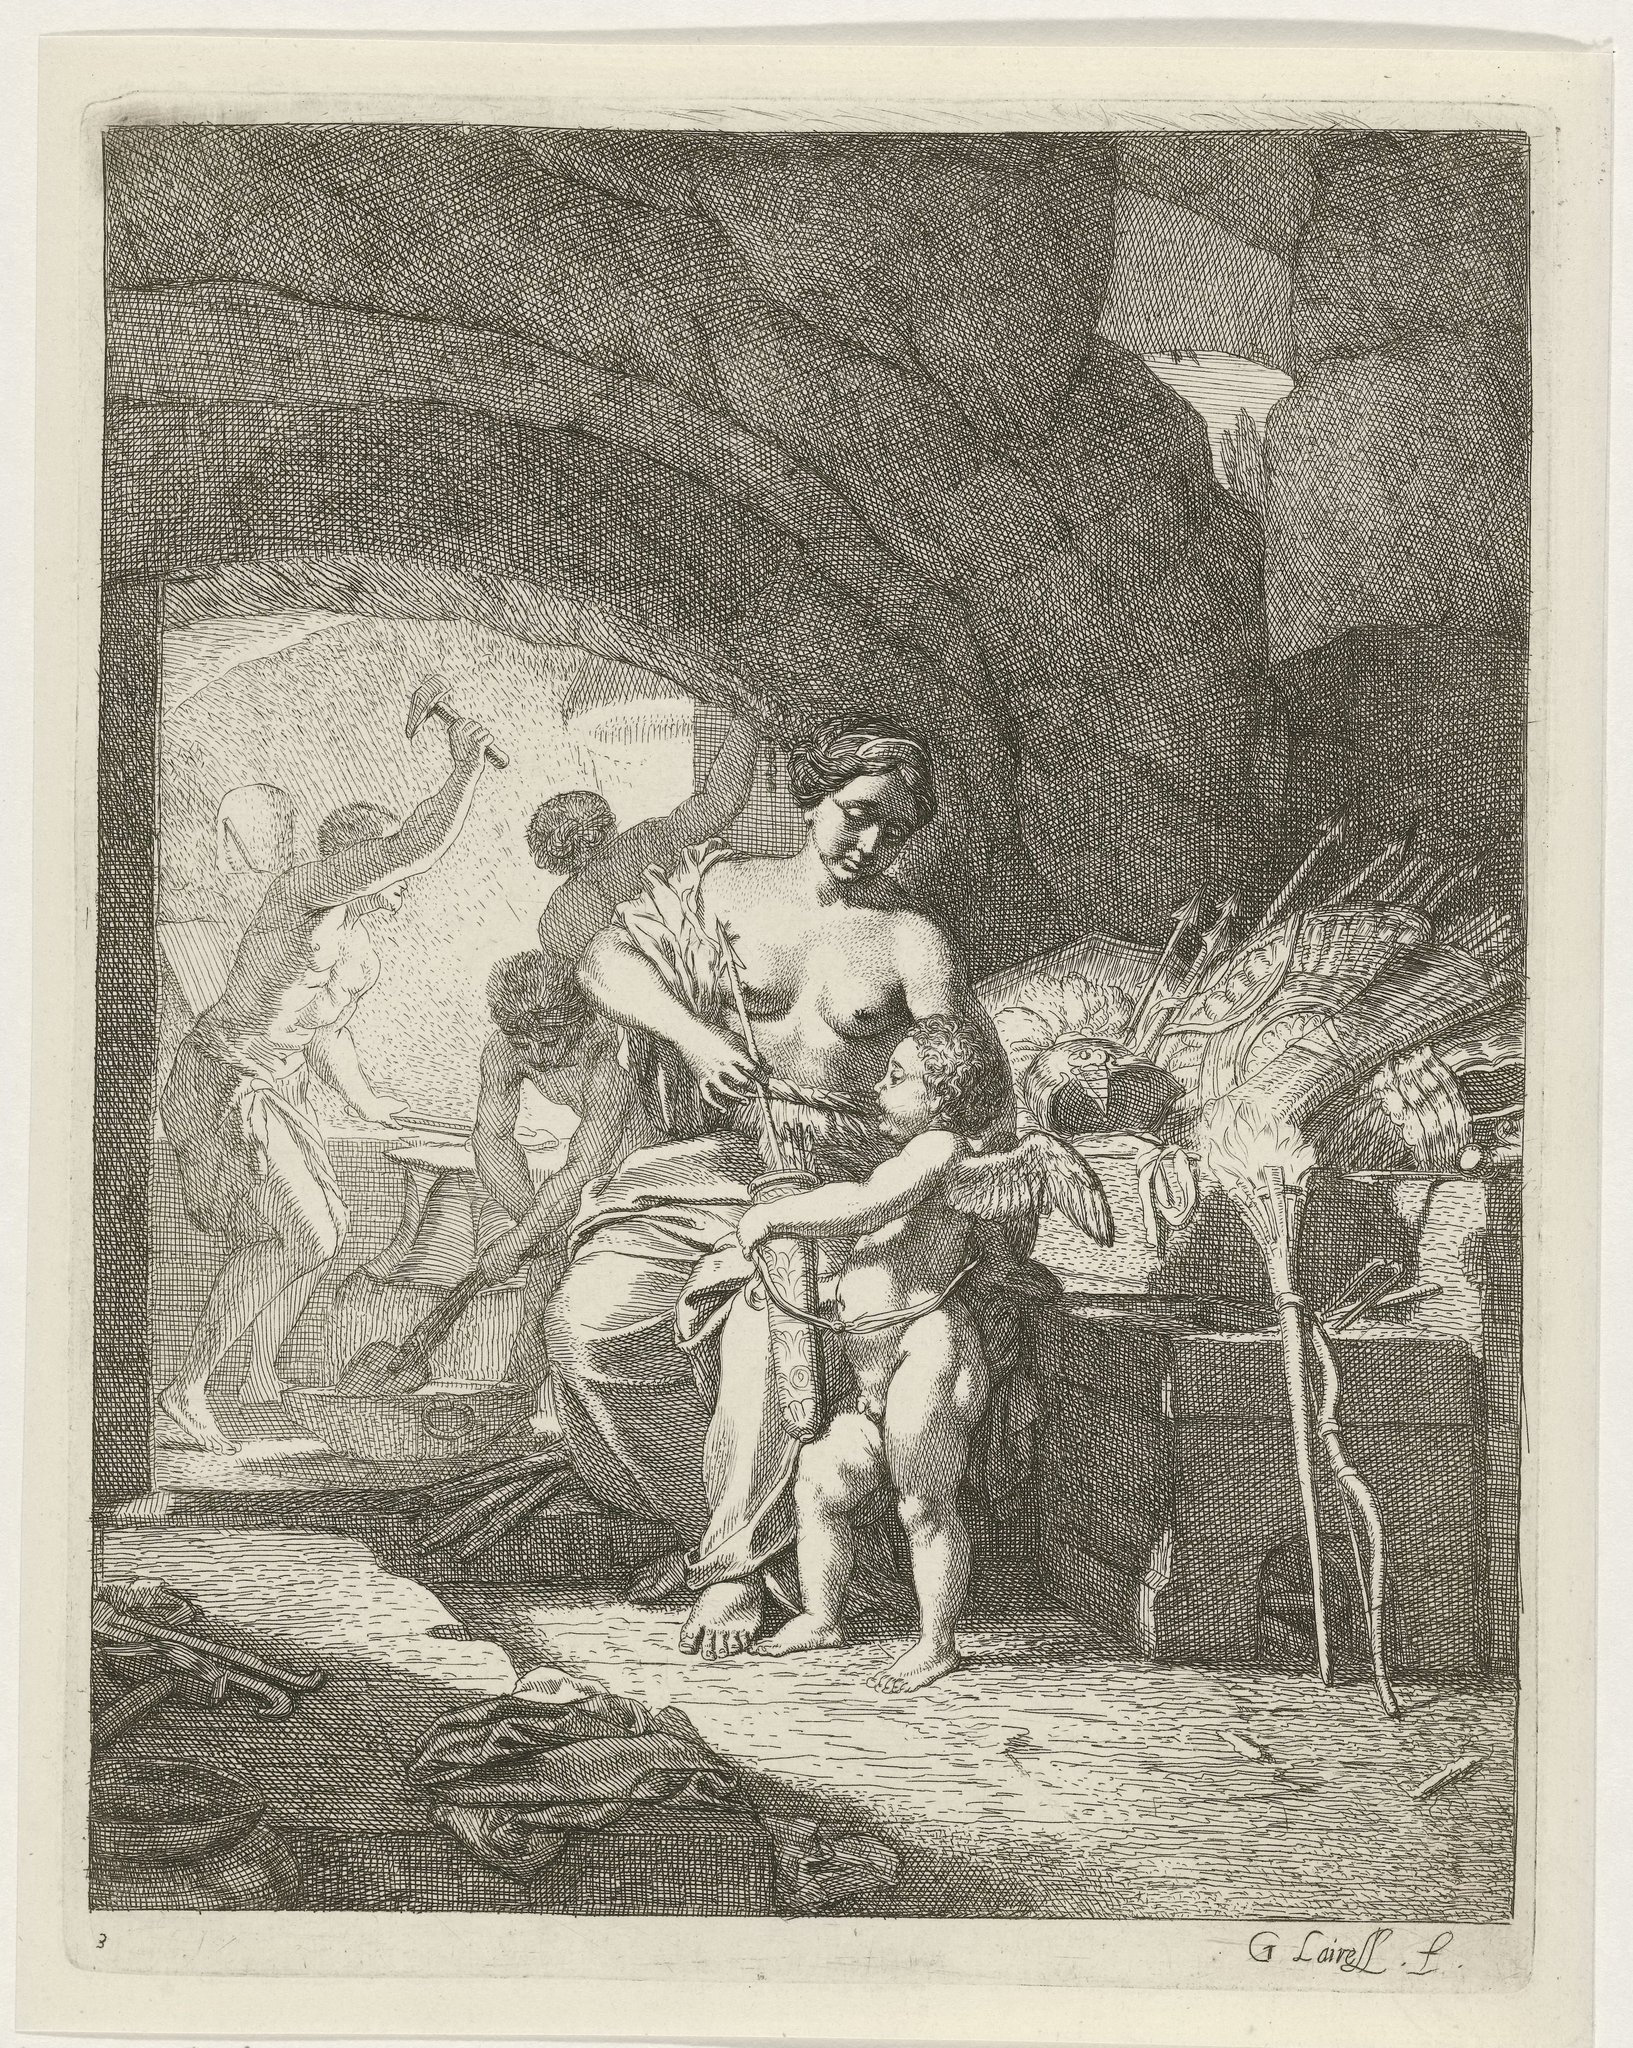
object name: print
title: Venus vult de pijlenkoker van Amor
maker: gerard de lairesse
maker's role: draughtsman, painter, print maker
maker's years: 1641-1711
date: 1675-1680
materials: paper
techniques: etching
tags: venus and cupid (cupid not being mere attribute)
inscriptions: collector's mark: Lugt 240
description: Venus vult de pijlenkoker van Amor met nieuwe pijlen, op de achtergrond zijn smeden aan het werk. De prent maakt deel uit van een vierdelige serie prenten met scènes uit het mythologische verhaal van Venus. Links in de marge genummerd: 3.